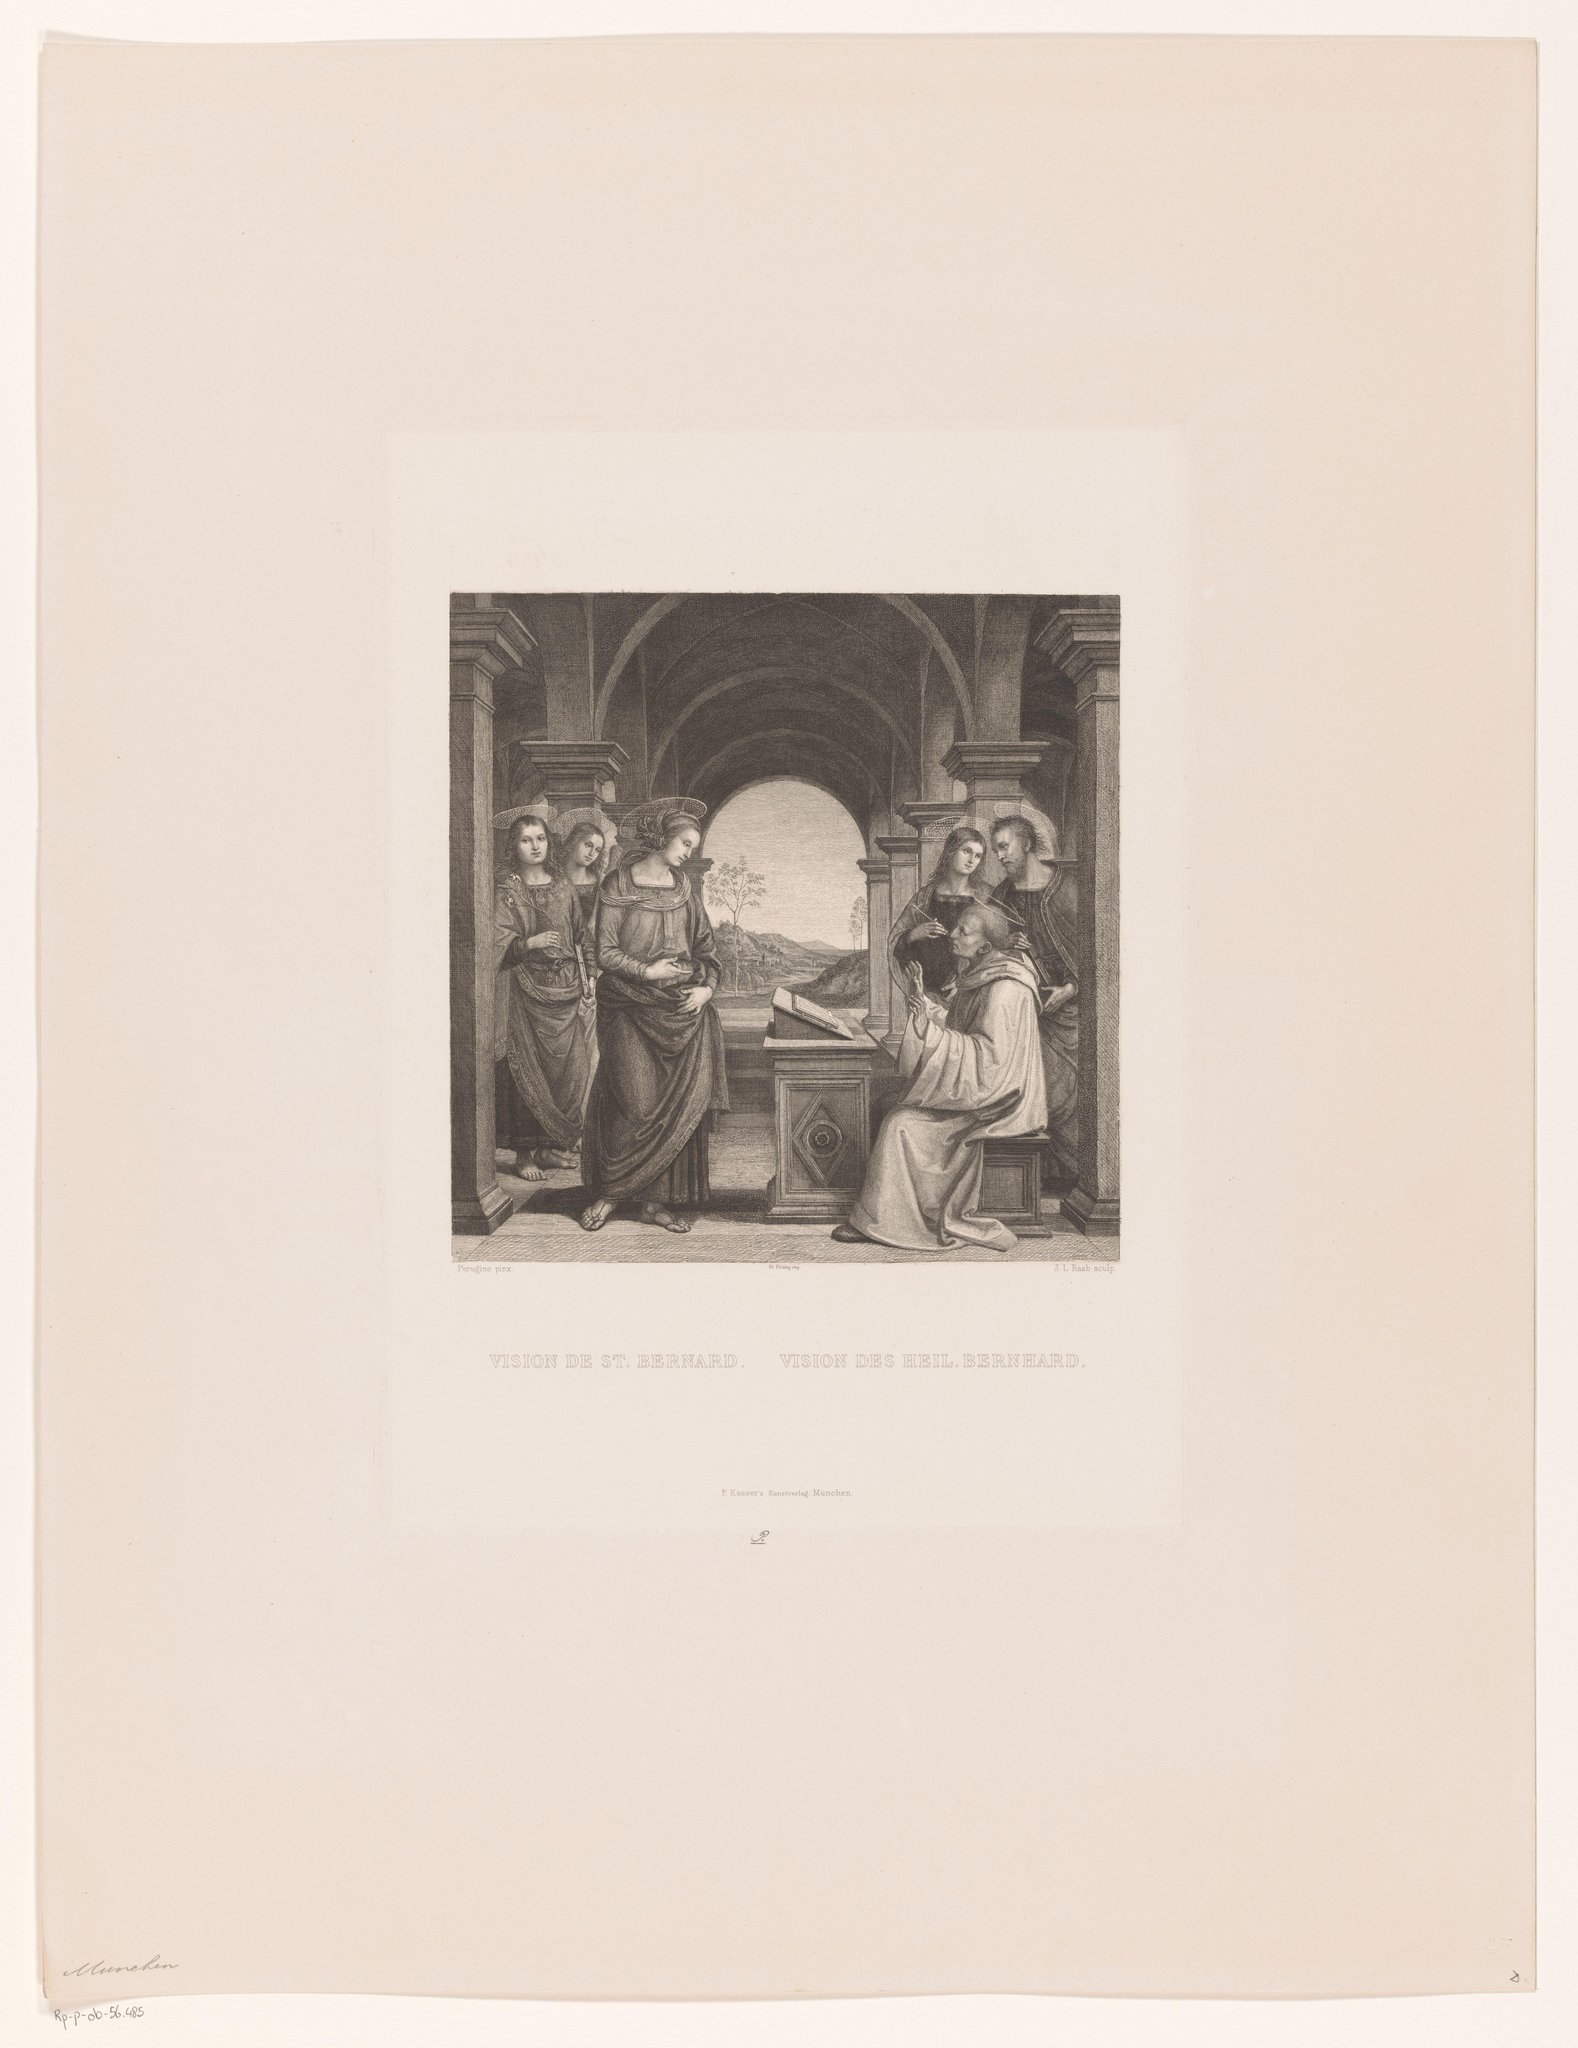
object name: print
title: Visioen van de heilige Bernardus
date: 1835-1899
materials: paper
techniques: etching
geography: munich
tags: the virgin mary, making a teaching gesture, appears to st. bernard of clairvaux writing at his desk ('doctrina')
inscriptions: number: ‘45’, collector's mark: Lugt 2228